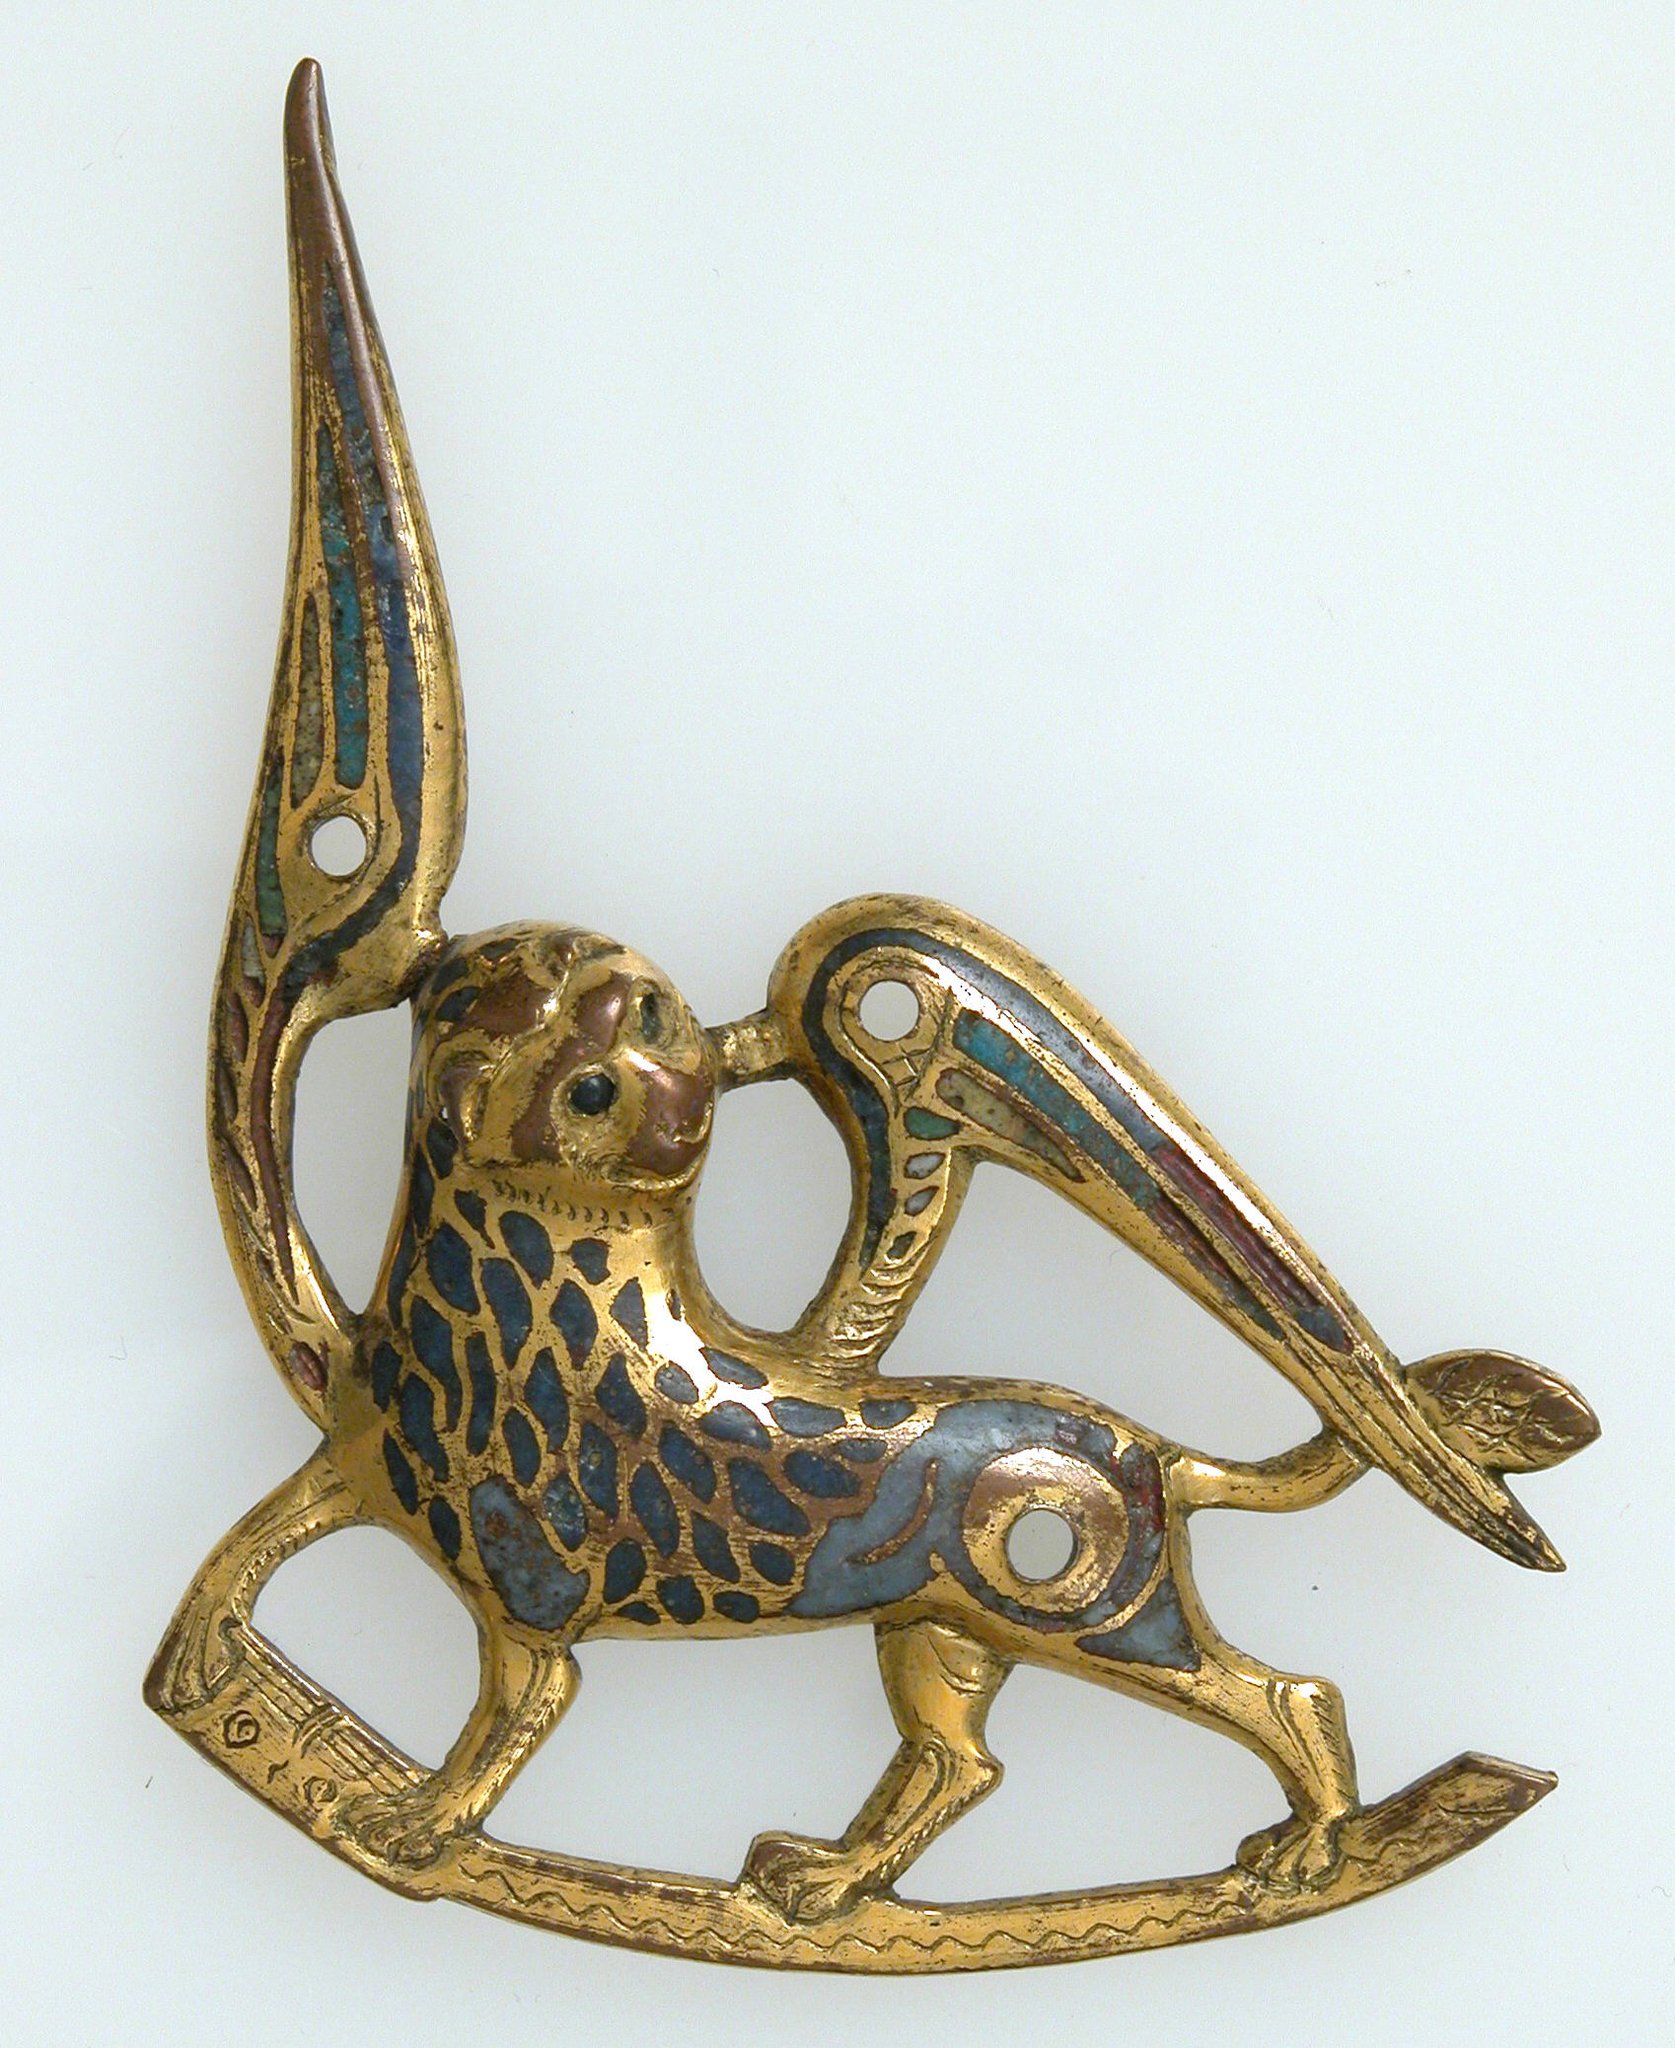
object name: appliqué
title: The Lion of Saint Mark (one of two appliqués from a book cover)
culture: french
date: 1200-1225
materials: copper, enamel, gilt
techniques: enamel, chasing, engraving, repoussé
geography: france